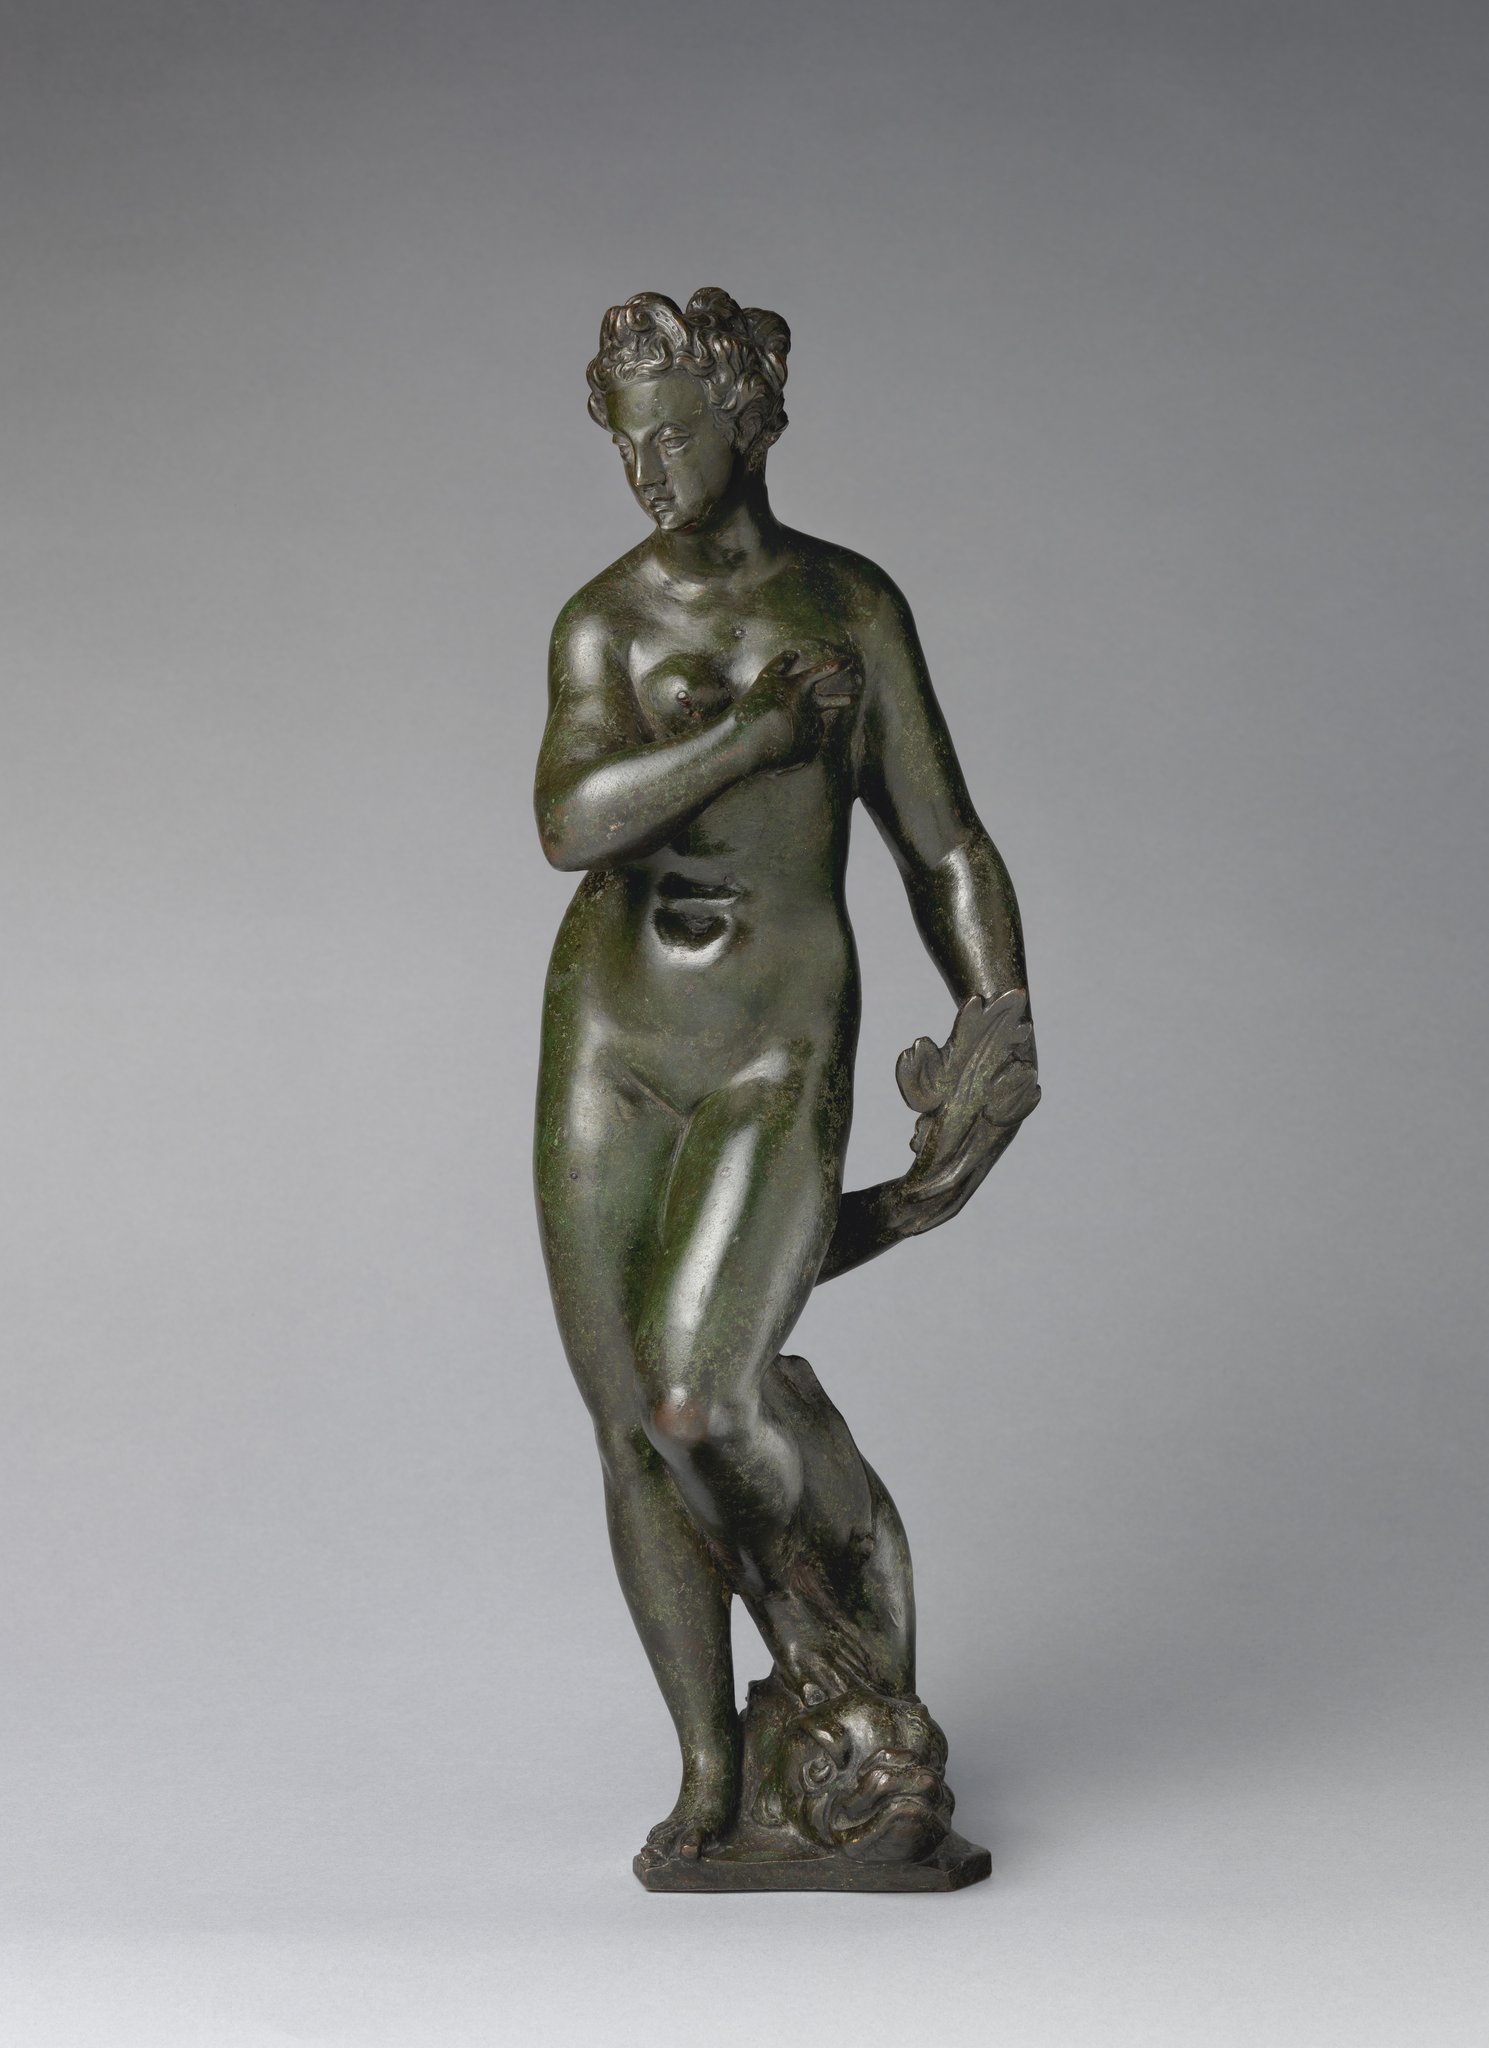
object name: statuette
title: Venus Marina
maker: girolamo campagna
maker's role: artist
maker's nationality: italian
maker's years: 1549-1625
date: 1567-1600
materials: bronze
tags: female nudes,venus